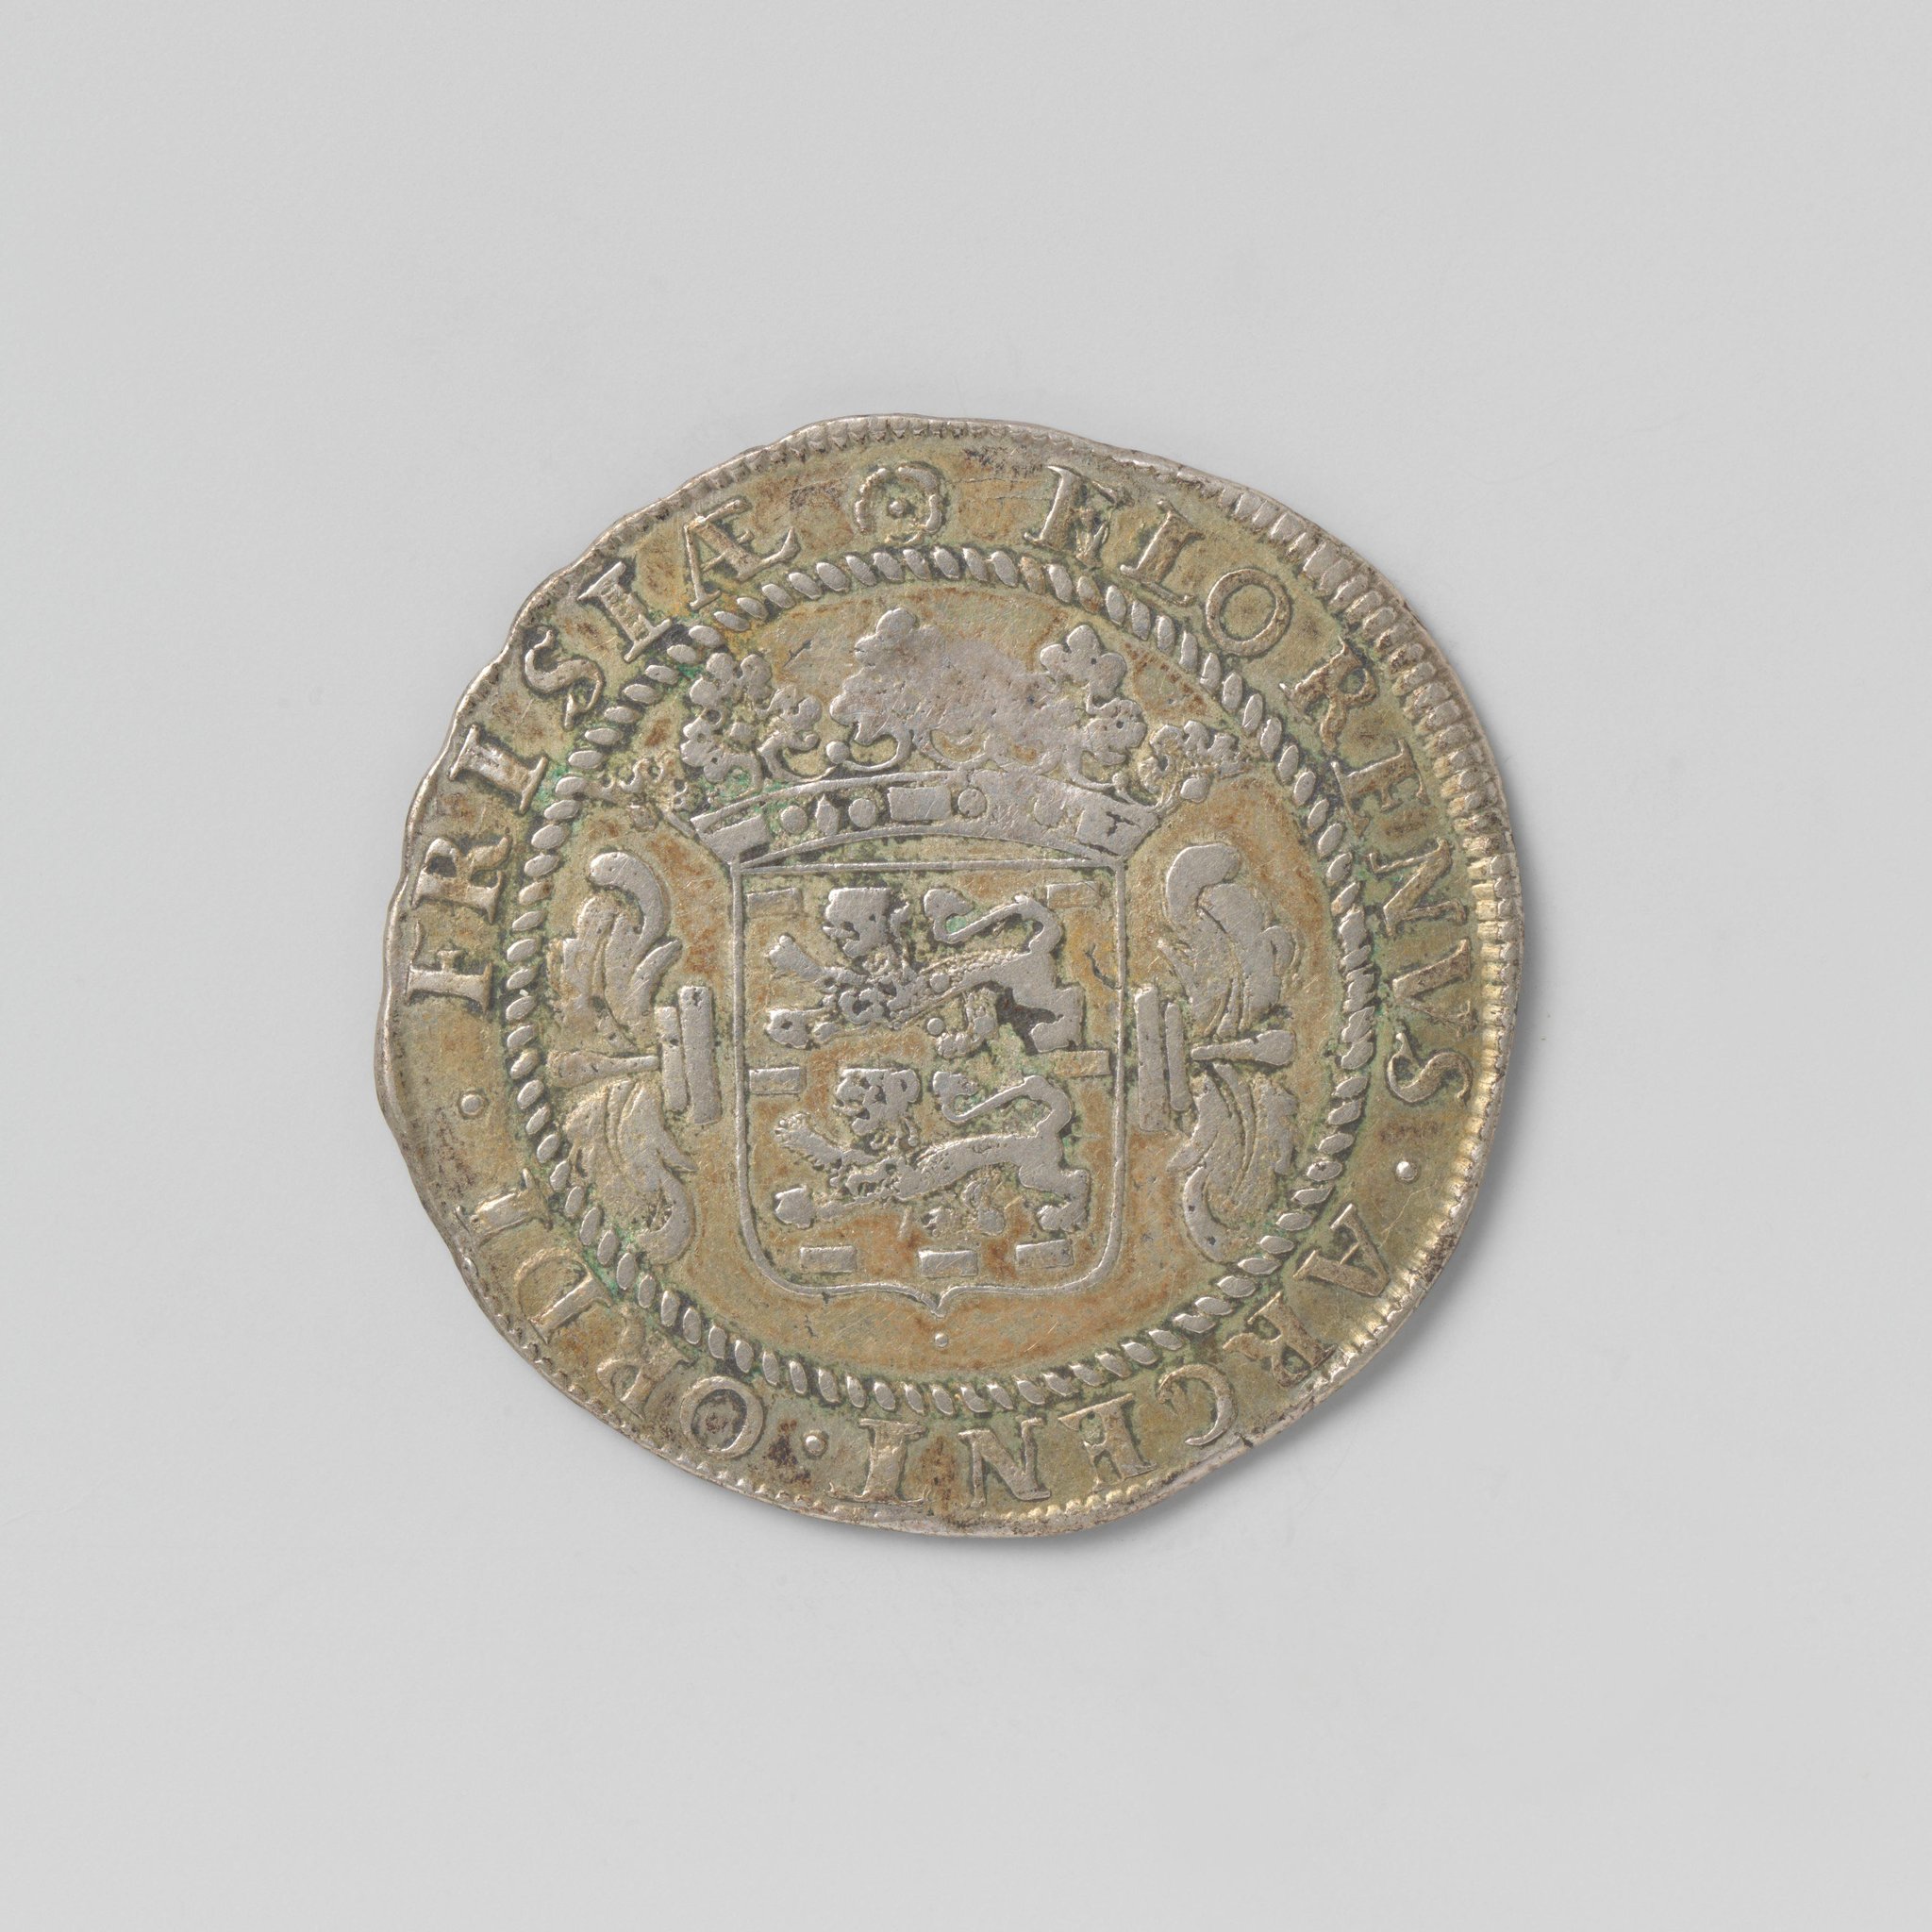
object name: coin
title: Halve florijn van Friesland, 1684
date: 1684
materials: silver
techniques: striking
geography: leeuwarden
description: Zilveen munt. Voorzijde: tussen waarde-aanduiding edelman met muts naar rechts. In rechterhand zwaard. In omschrift jaartal Keerzijde: op kort gebloemd kruis gekroond wapenschild van Friesland.